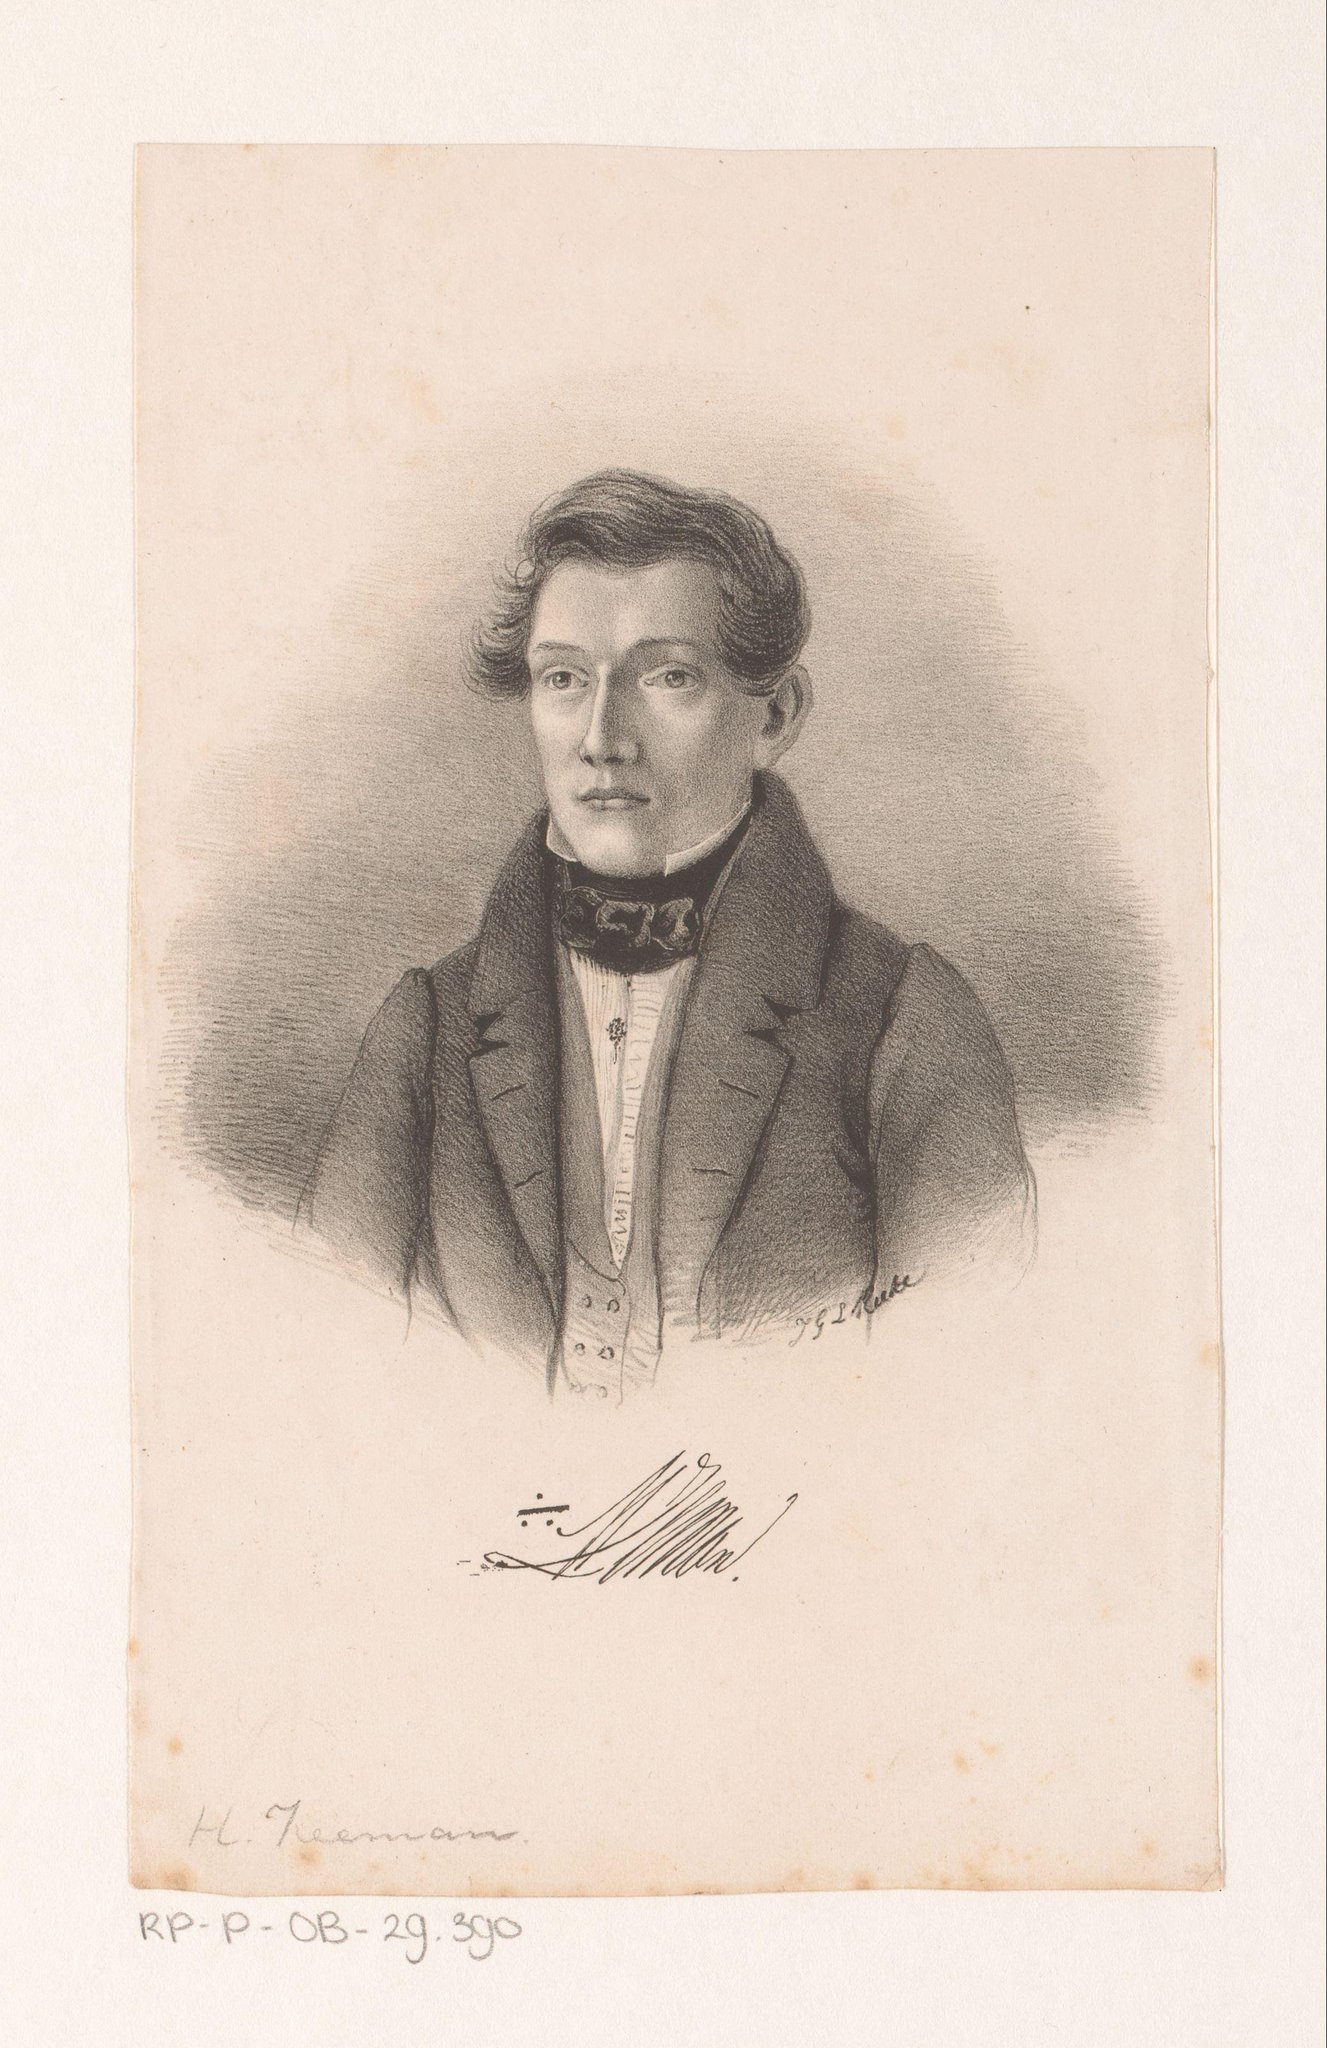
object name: print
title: Portret van H. Zeeman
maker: johan george lodewijk rieke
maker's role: draughtsman, print maker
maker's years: 1817-1898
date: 1827-1898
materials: paper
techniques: lithograph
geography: netherlands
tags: historical persons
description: Onder het portret de signatuur van de geportretteerde.